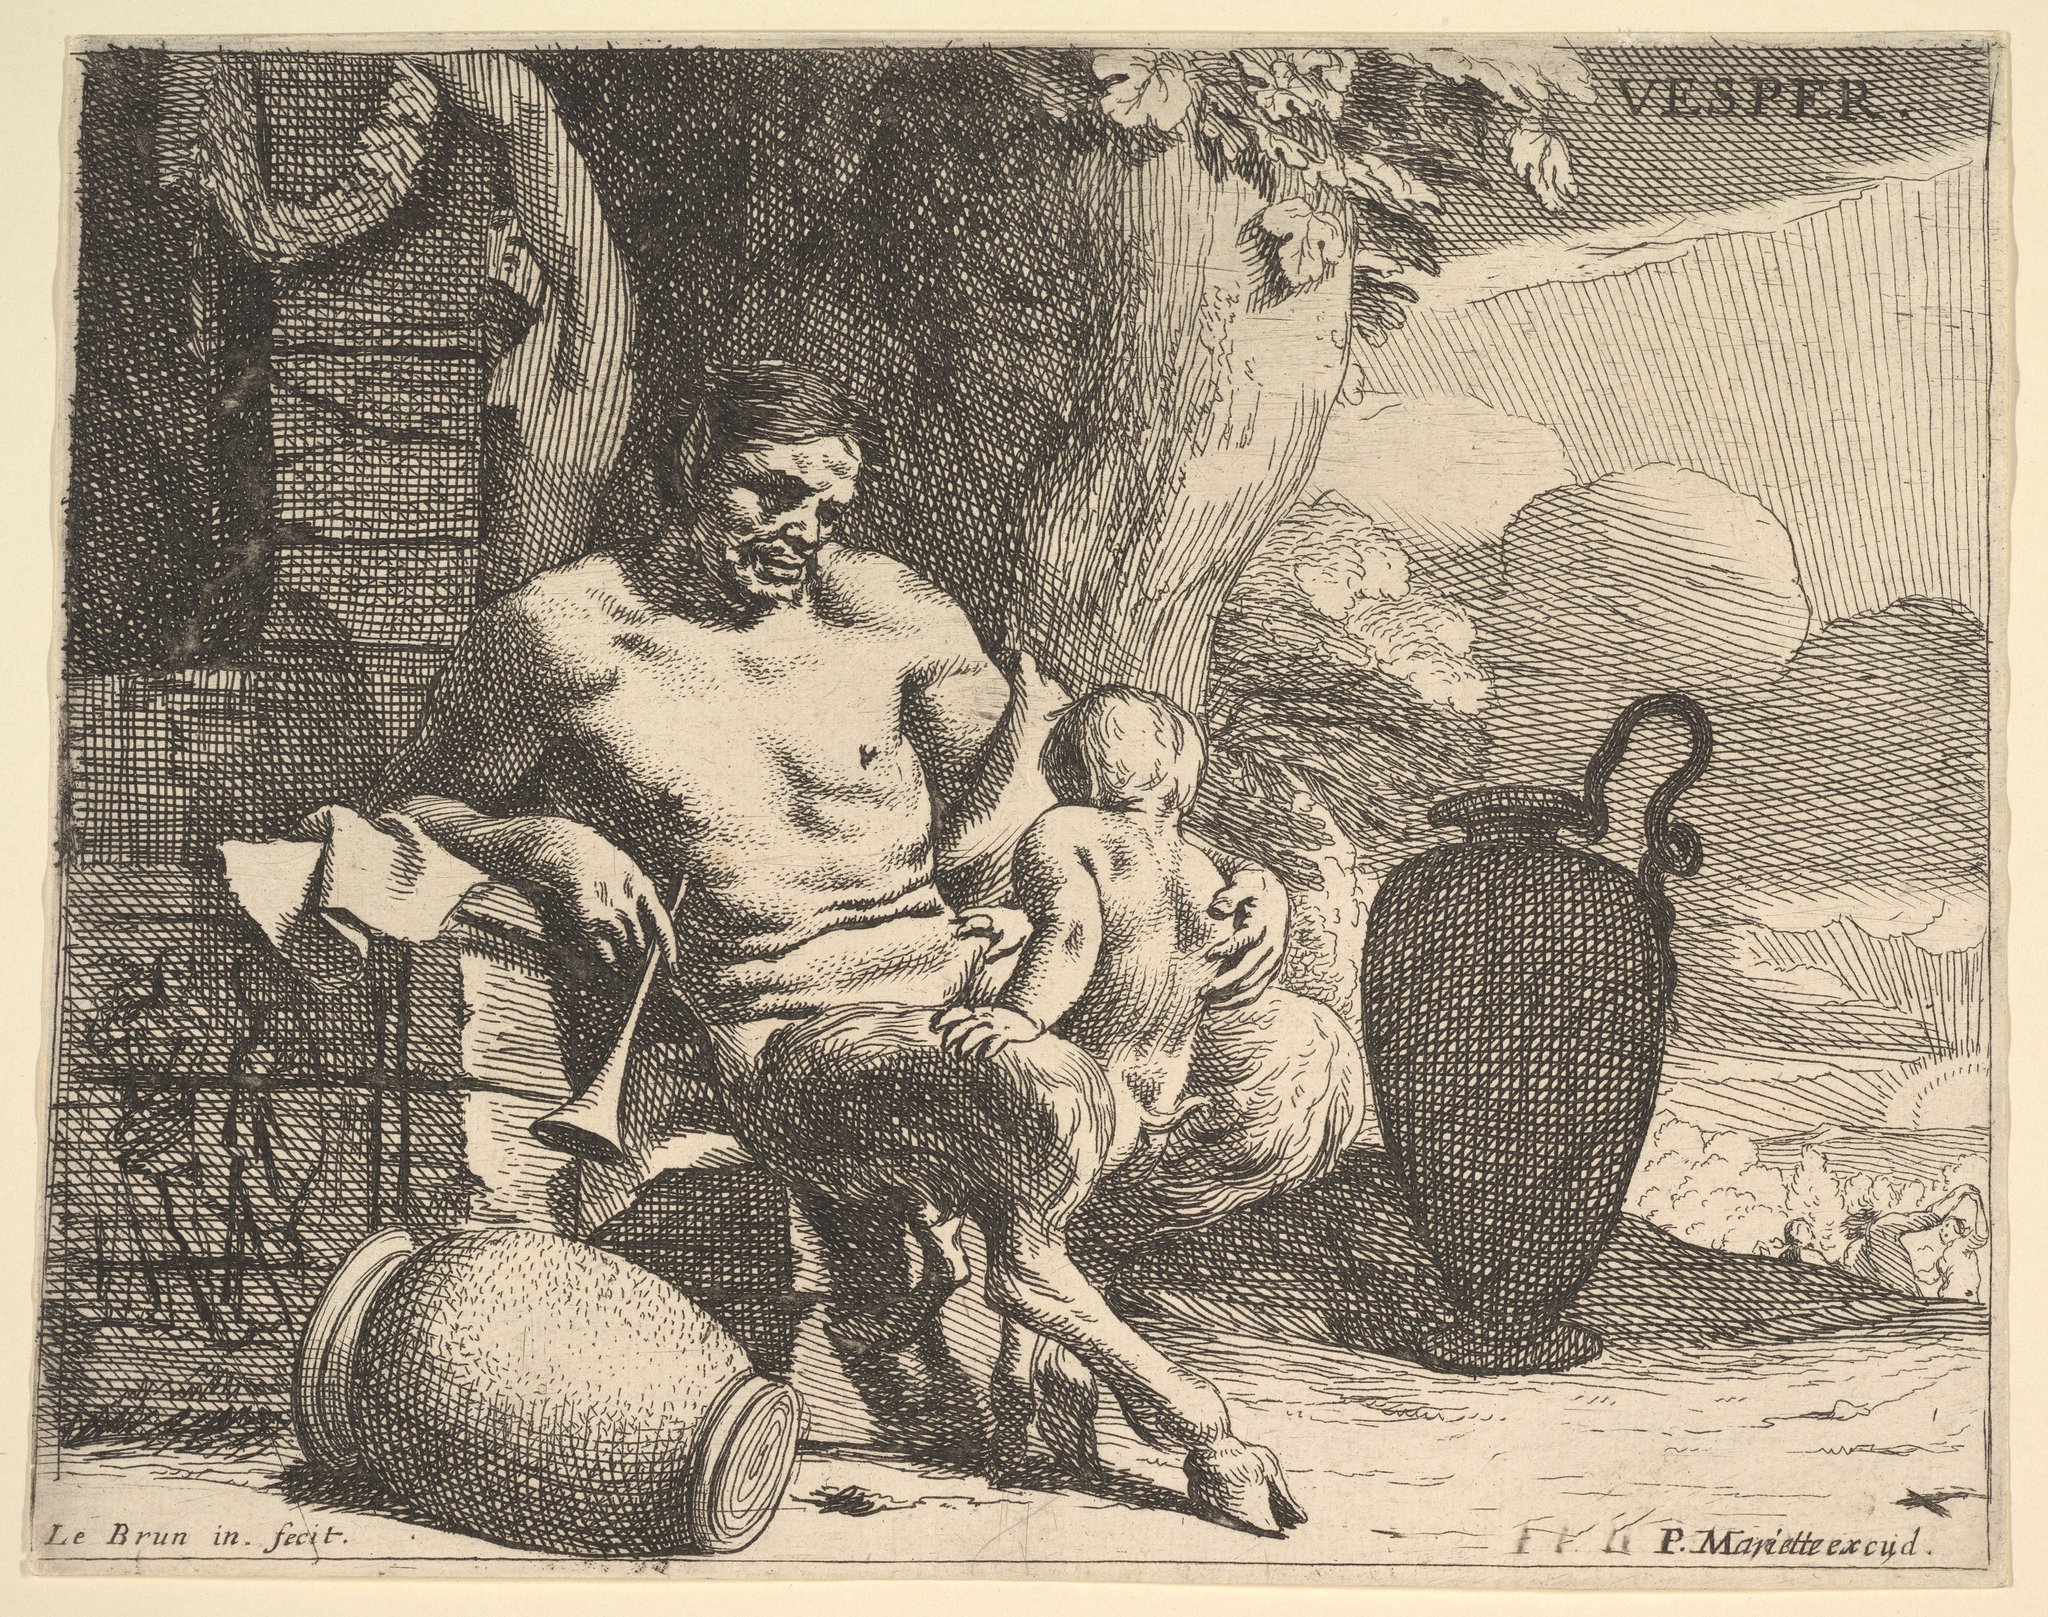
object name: print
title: Evening: a seated satyr clasps his child, a figure hangs a garland on a pier beyond, from "Hours of the Day"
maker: charles le brun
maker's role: artist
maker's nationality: french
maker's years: 1619-1690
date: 1640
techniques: etching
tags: satyrs